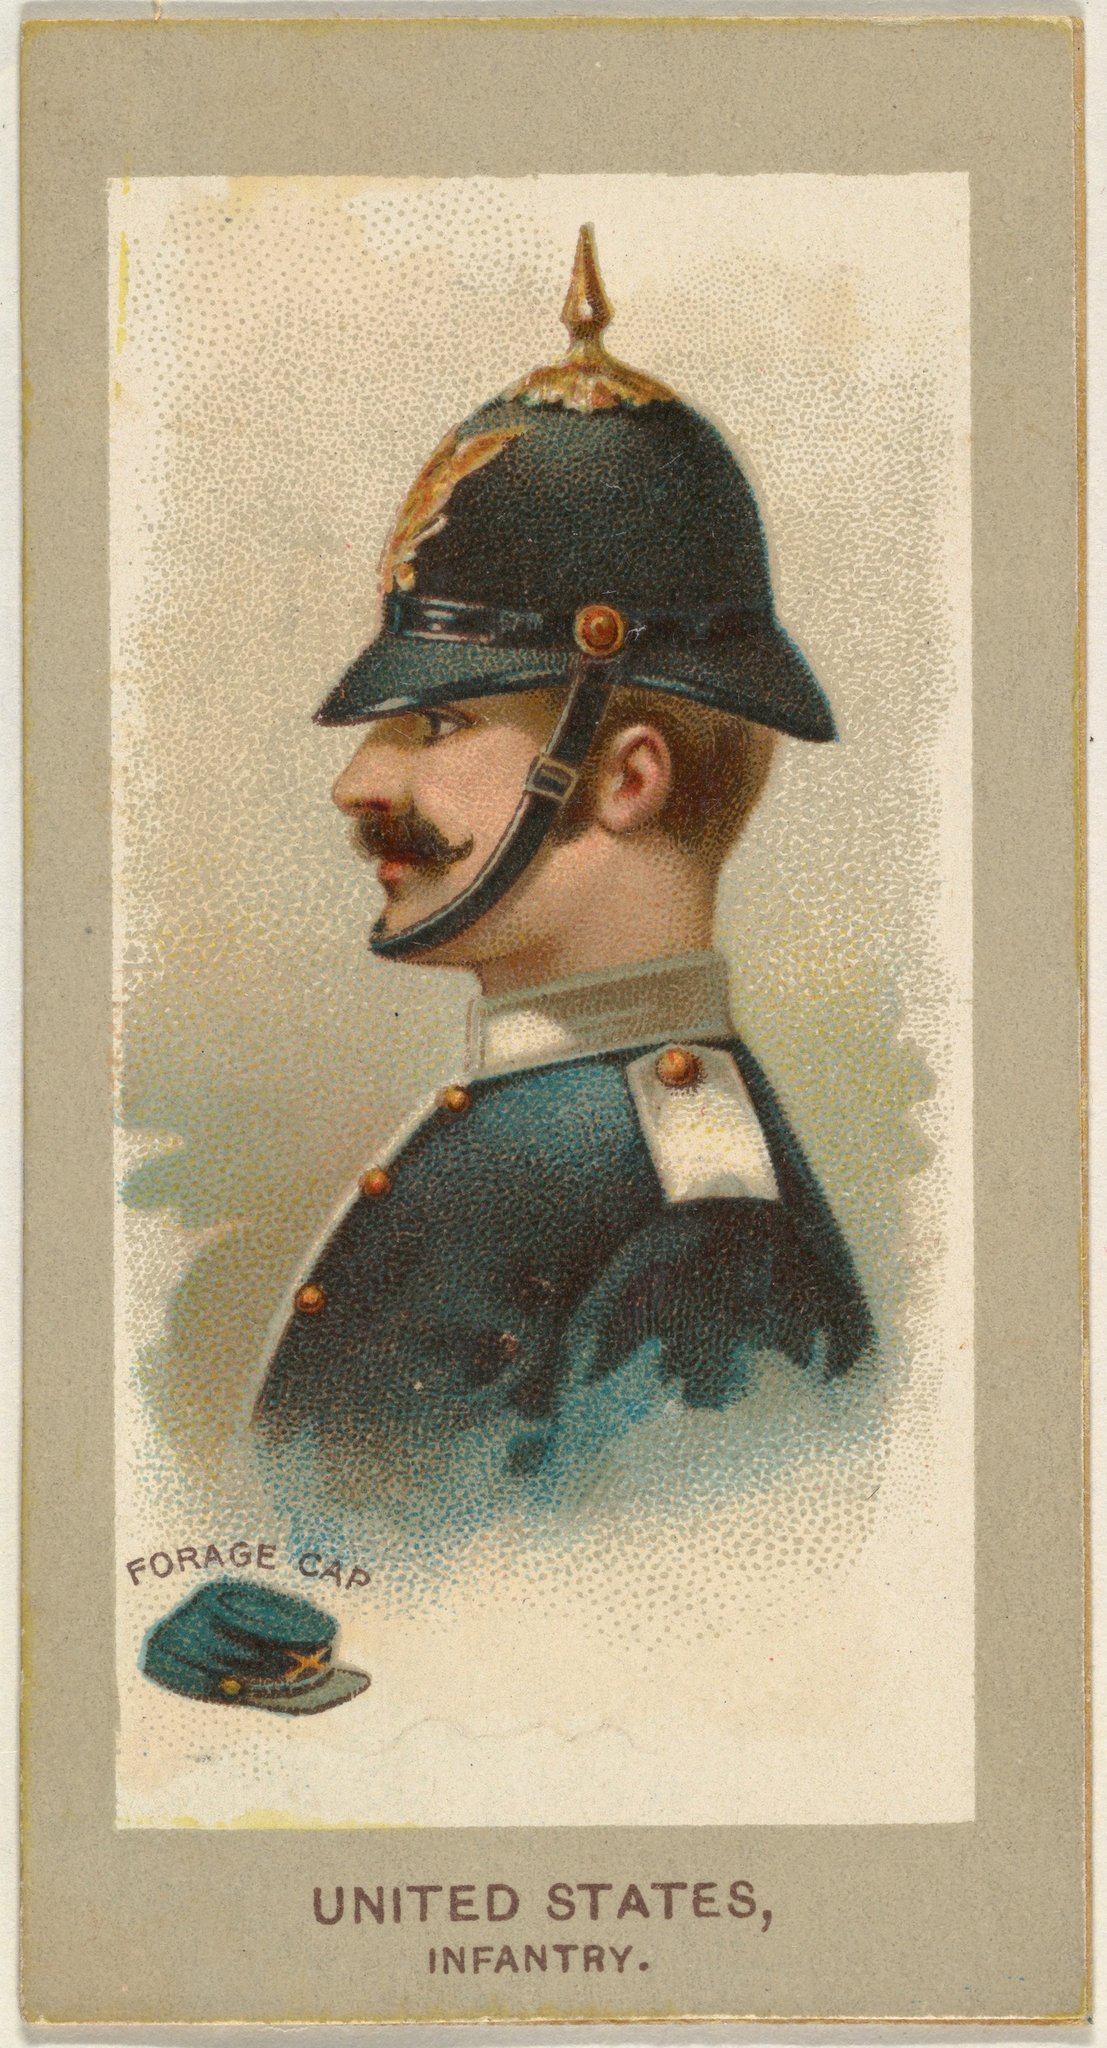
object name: print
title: Forage Cap, Infantry, United States, from the Military Uniforms series (T182) issued by Abdul Cigarettes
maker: abdul cigarettes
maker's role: publisher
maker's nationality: american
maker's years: 1881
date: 1881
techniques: color lithograph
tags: military,military clothing,profiles